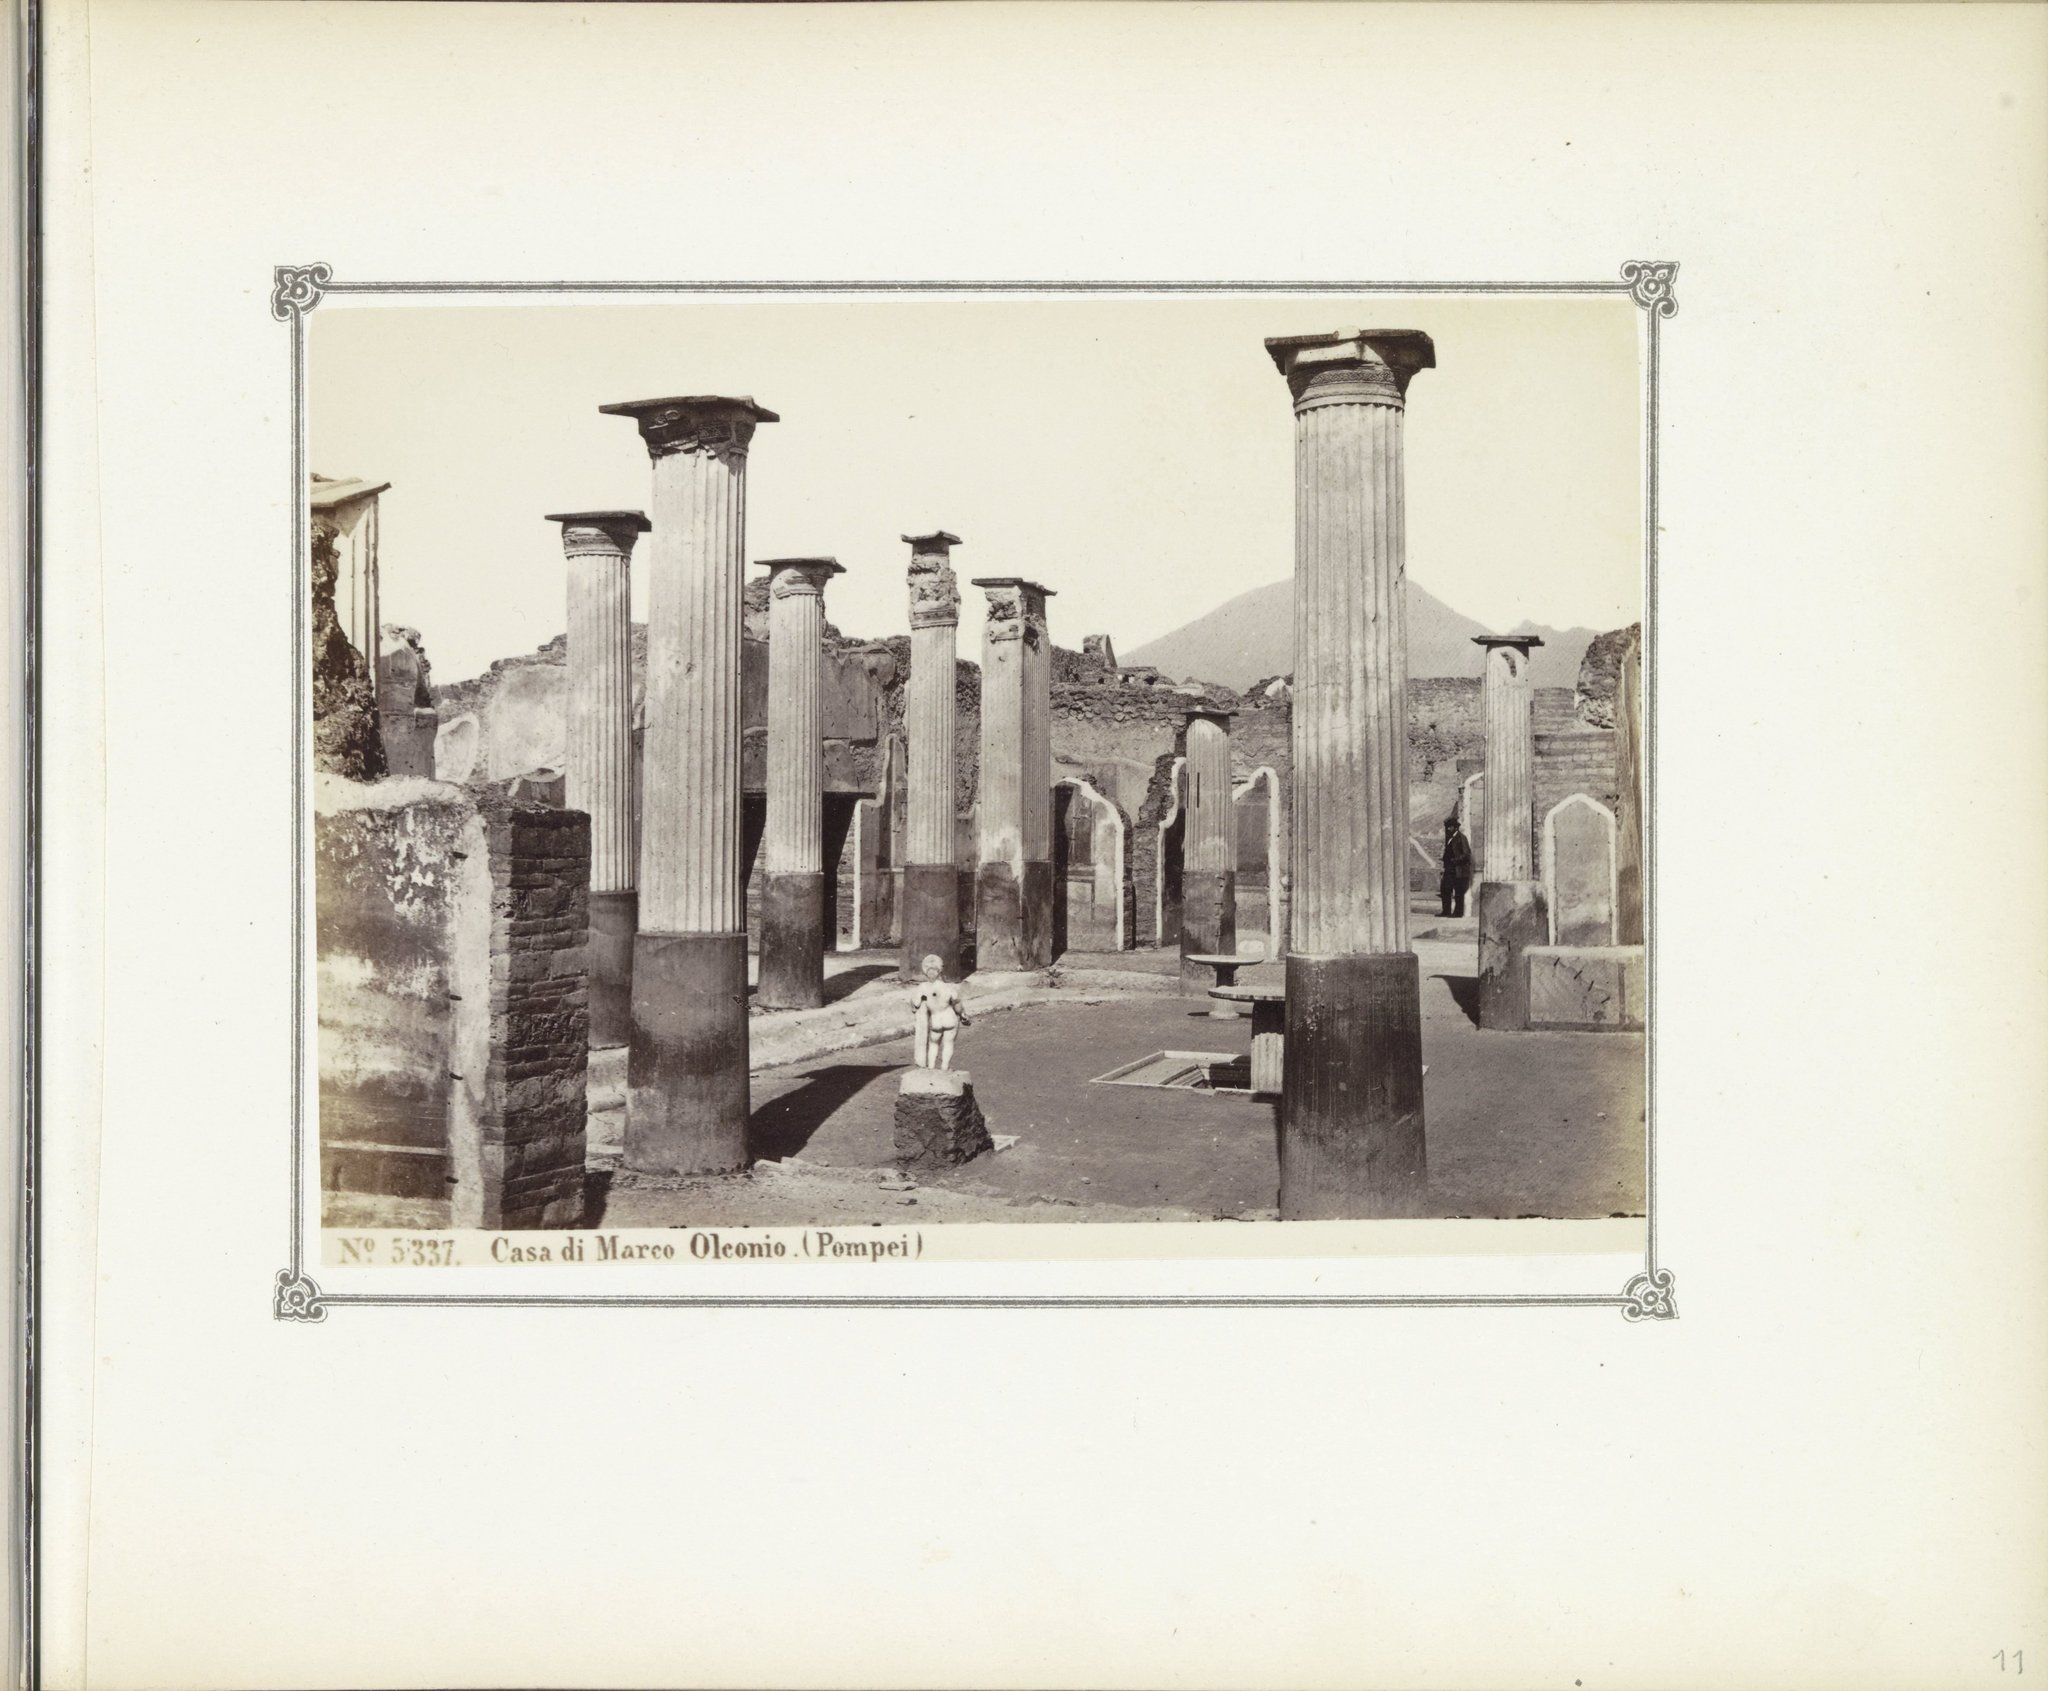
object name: photograph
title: Casa di Marco Olconio. (Pompei)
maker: giorgio sommer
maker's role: fotograaf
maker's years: 1834-1914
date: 1860-1900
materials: paper, photographic support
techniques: albumen print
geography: pompeii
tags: villa, excavation ~ archaeology, pompeii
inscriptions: number: ‘5337’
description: Onderdeel van Fotoalbum met opnames van opgravingen in Pompeï door Giorgio Sommer.